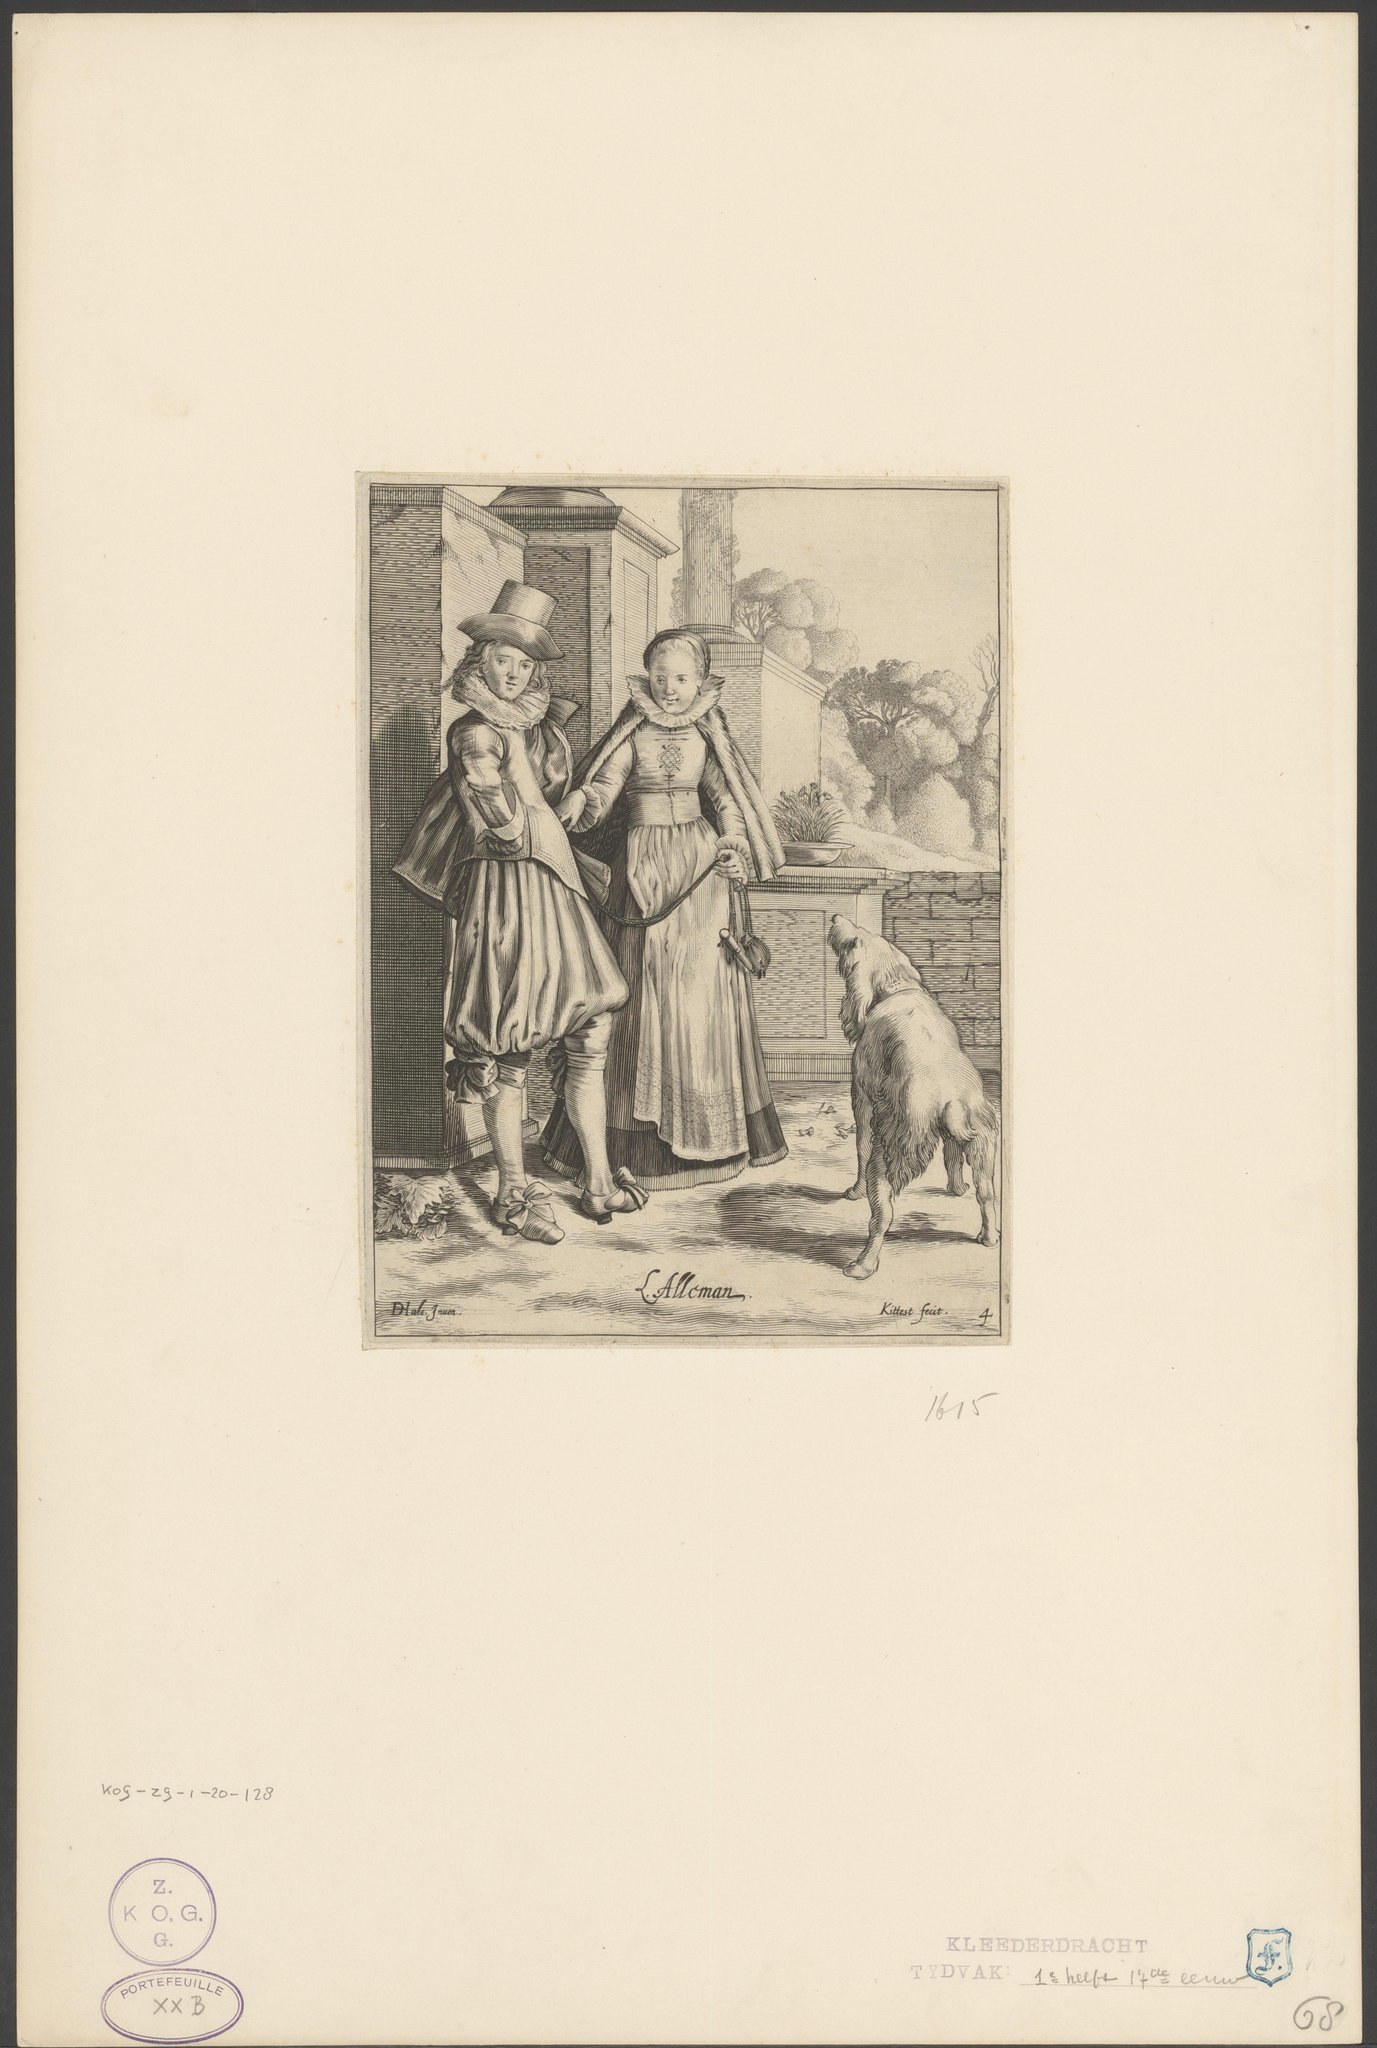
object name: print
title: Elegant paar in Duitse kleding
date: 1610-1638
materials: paper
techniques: engraving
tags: handkerchief (+ women's clothes), bow (ornamental part of clothing) (+ men's clothes), cape, head-gear: hat (+ men's clothes), shoes, sandals (+ men's clothes), trousers, breeches, etc. (breeches) (+ men's clothes), europeans: germans, germany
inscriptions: collector's mark: Lugt 963, collector's mark: Lugt 1641, stamp, stamp:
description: Voor een gebouw met tuinmuur staat een elegant paar in Duitse kleding uit ca. 1620. Voor het paar een hond. De prent maakt deel uit van een serie met zes prenten over kostuums in Europa. Onderwerpsrubrieken binnen de Atlas Zeden en Gewoonten: Zeden en Gewoonten in Engeren Zin, De Kleeding, Kleederdrachten (tijdvakken), Het begin der 17de eeuw. (De Fransche mode).